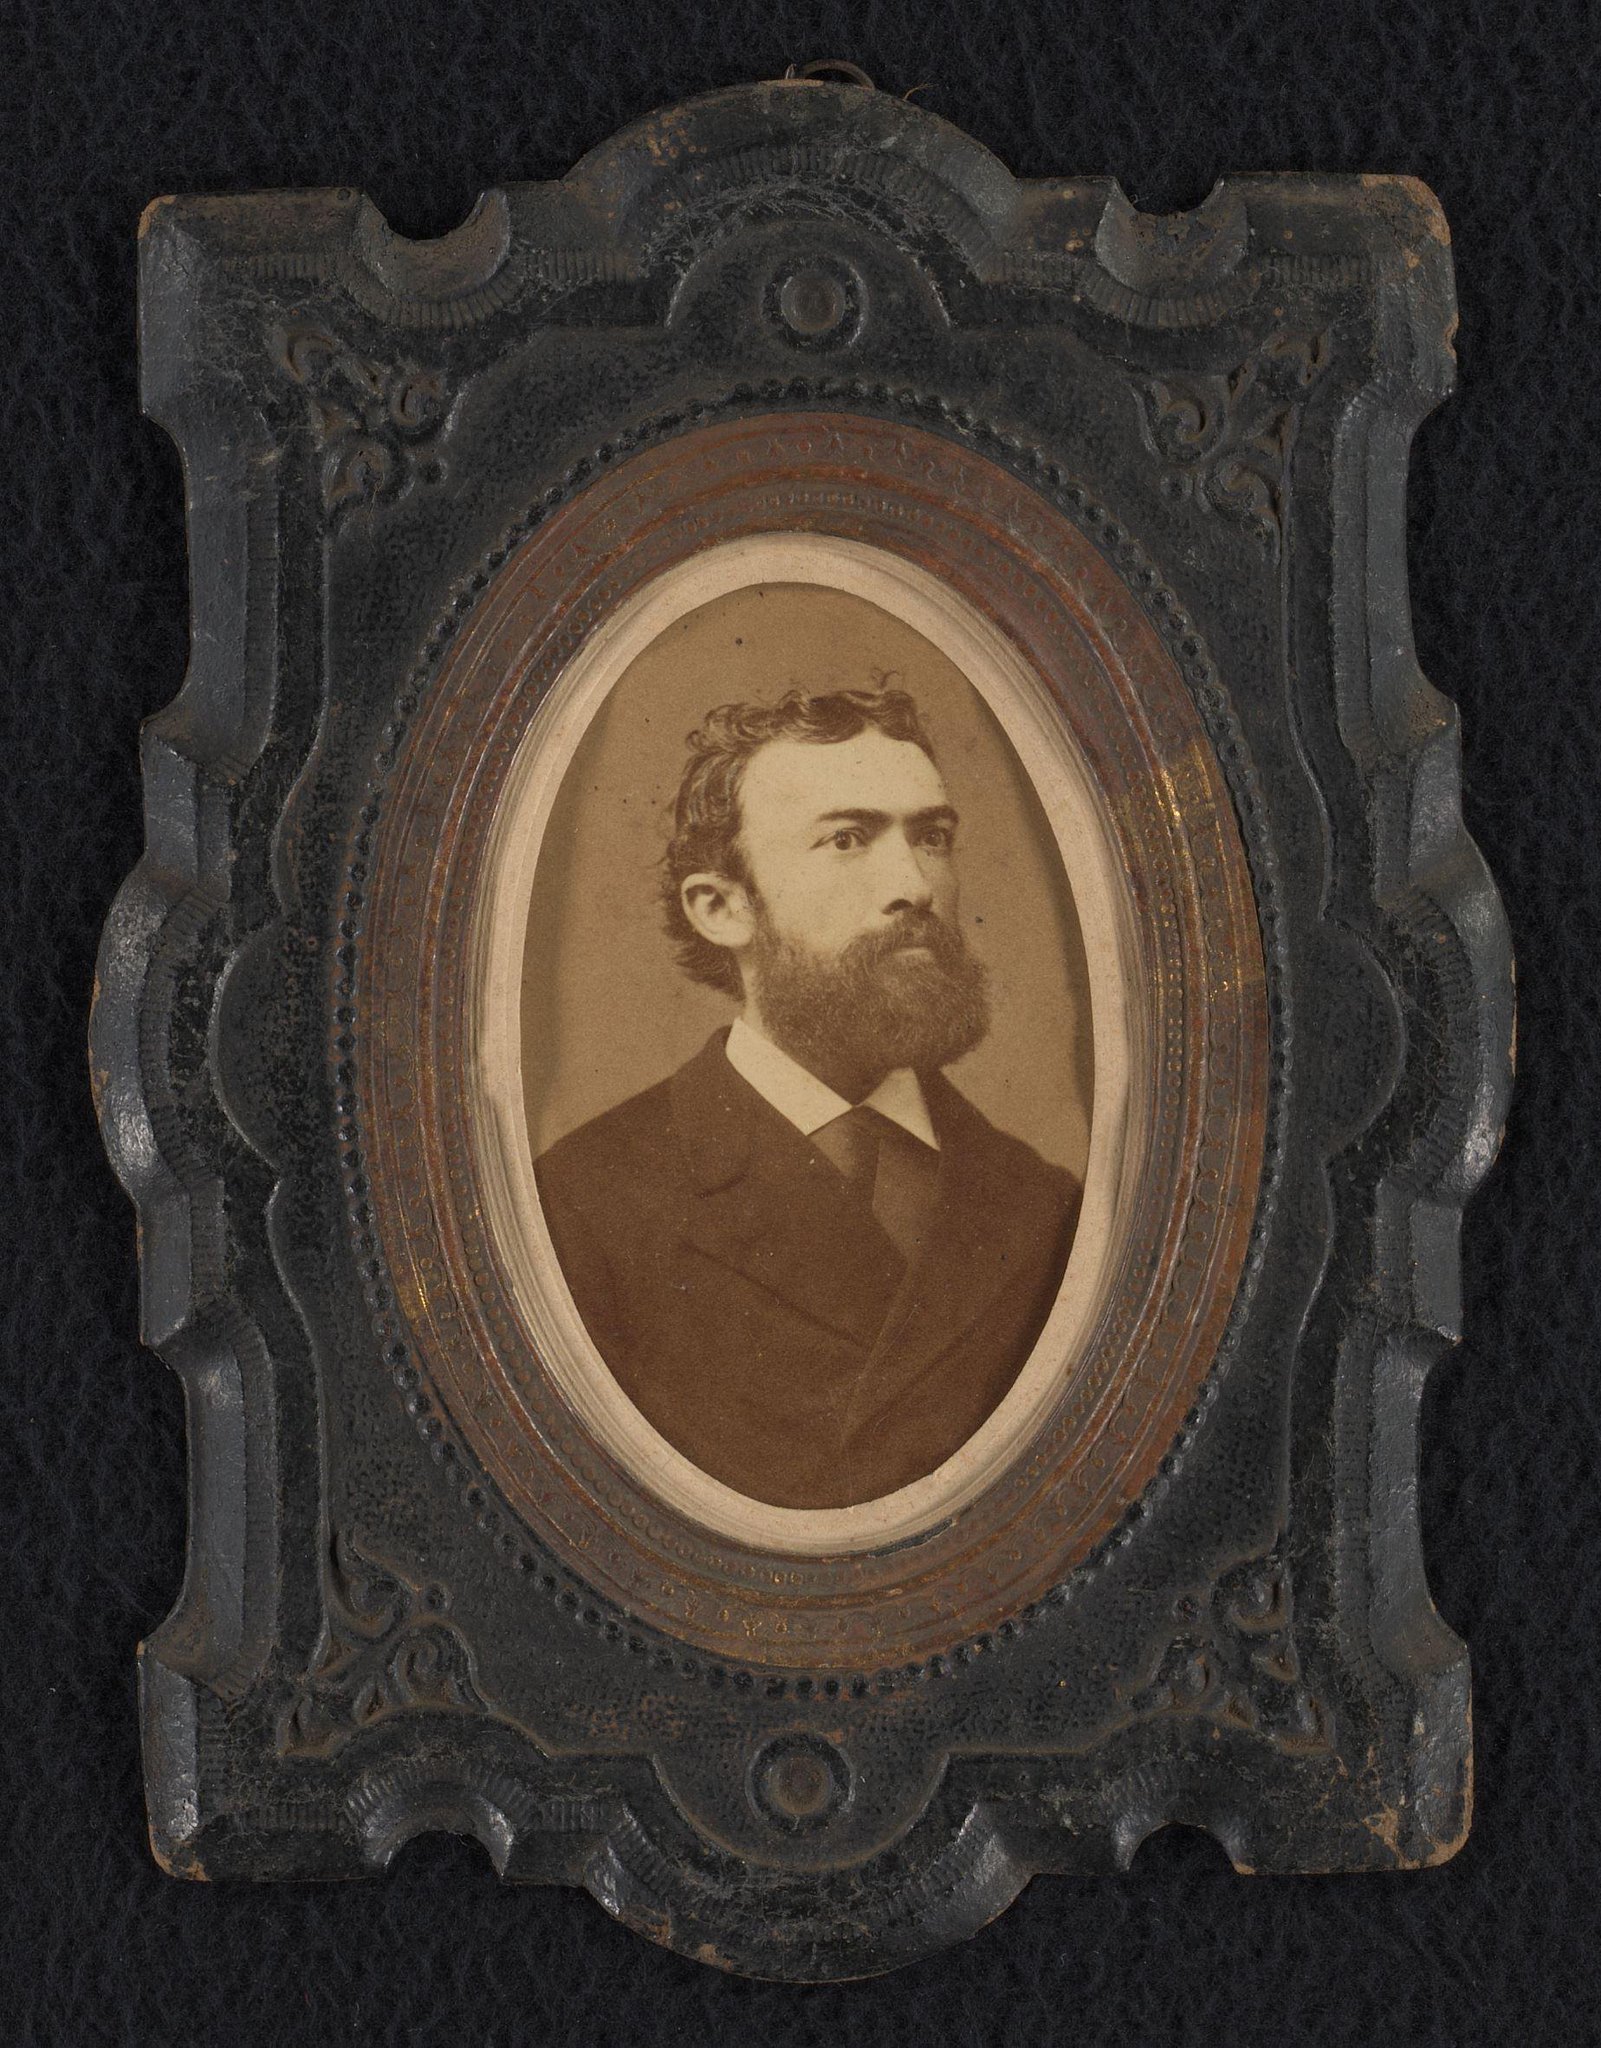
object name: photograph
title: Portret van een man met baard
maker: henri willem schrier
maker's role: fotograaf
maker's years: 1859-1920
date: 1860-1867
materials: metal, paper, photographic support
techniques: albumen print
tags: adult man, historical persons, beard